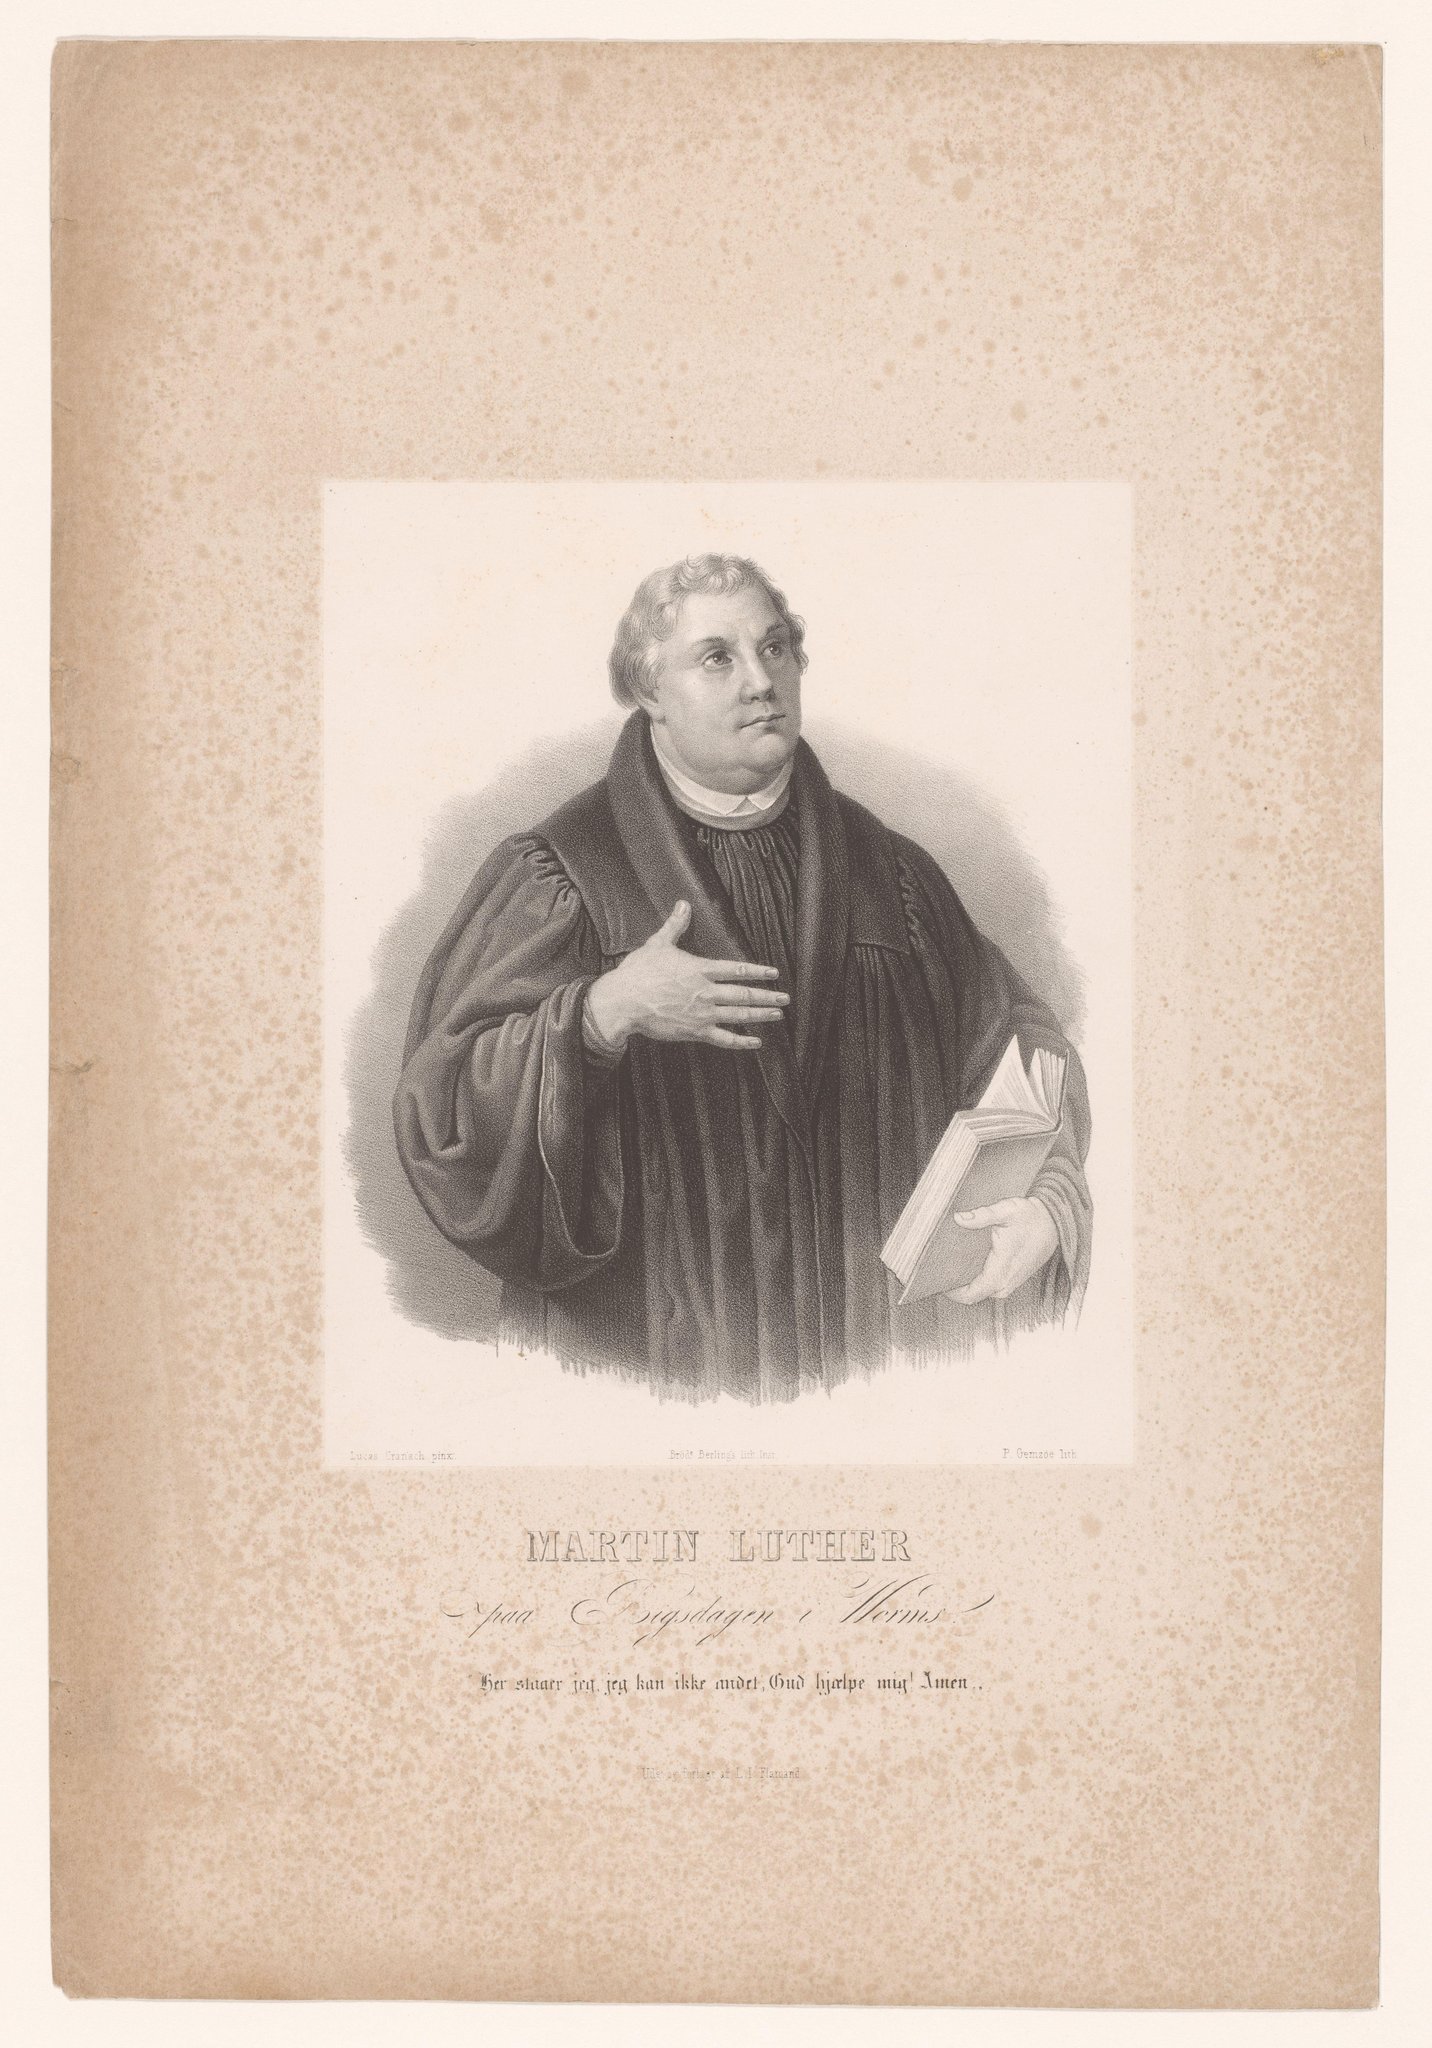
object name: print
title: Portret van Maarten Luther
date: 1821-1879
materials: paper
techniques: lithograph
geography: copenhagen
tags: priest, martin luther, historical persons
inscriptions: signature: ‘P. Gemzöe lith’, inscription: ‘Martin Luther / paa Rigsdagen i Worms.’, signature: ‘Lucas Cranach pinx’, signature: ‘Udg og forlagt af L.J. Flamand’, signature: ‘Bröde Berlings lith.Inst.’, inscription: ‘"Her staaer jeg, jeg kan ikke andet. hud hjoelpe mig! Amen."’, collector's mark: Lugt 2228